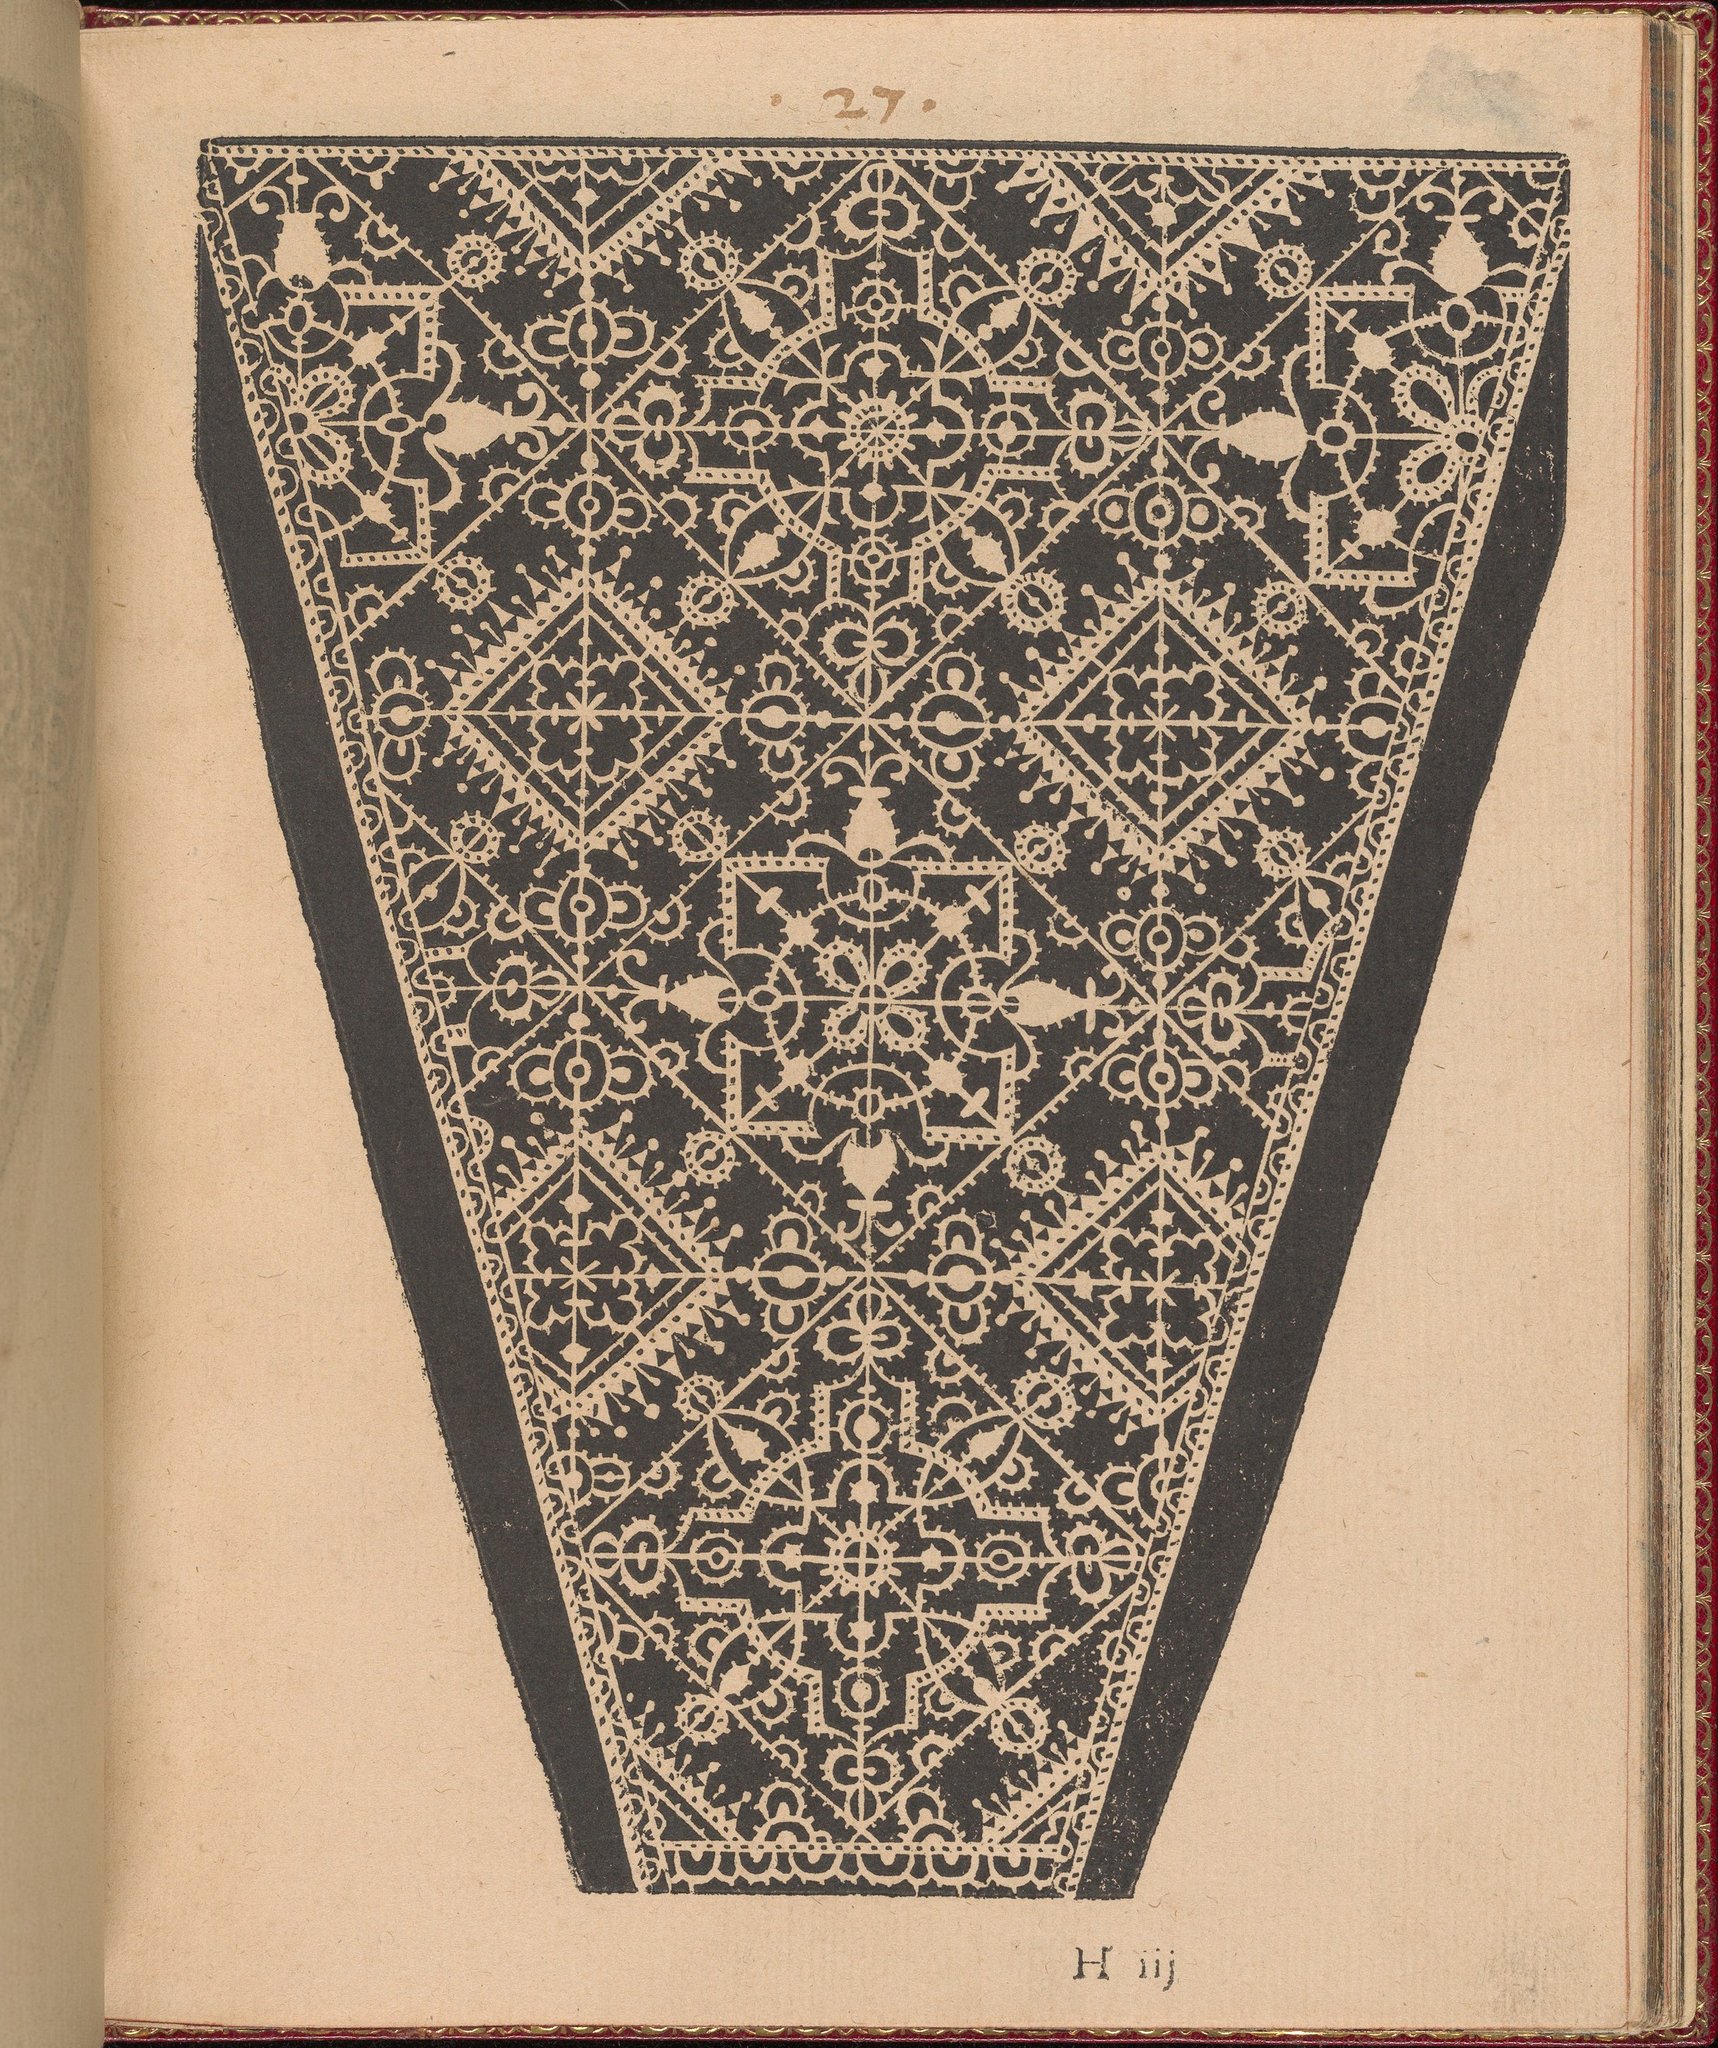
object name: book print ornament architecture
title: Les Singuliers et Nouveaux Portraicts... page 31 (recto)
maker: federico de vinciolo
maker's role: designer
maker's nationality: italian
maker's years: 1582-1599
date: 1588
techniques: woodcut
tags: ornament